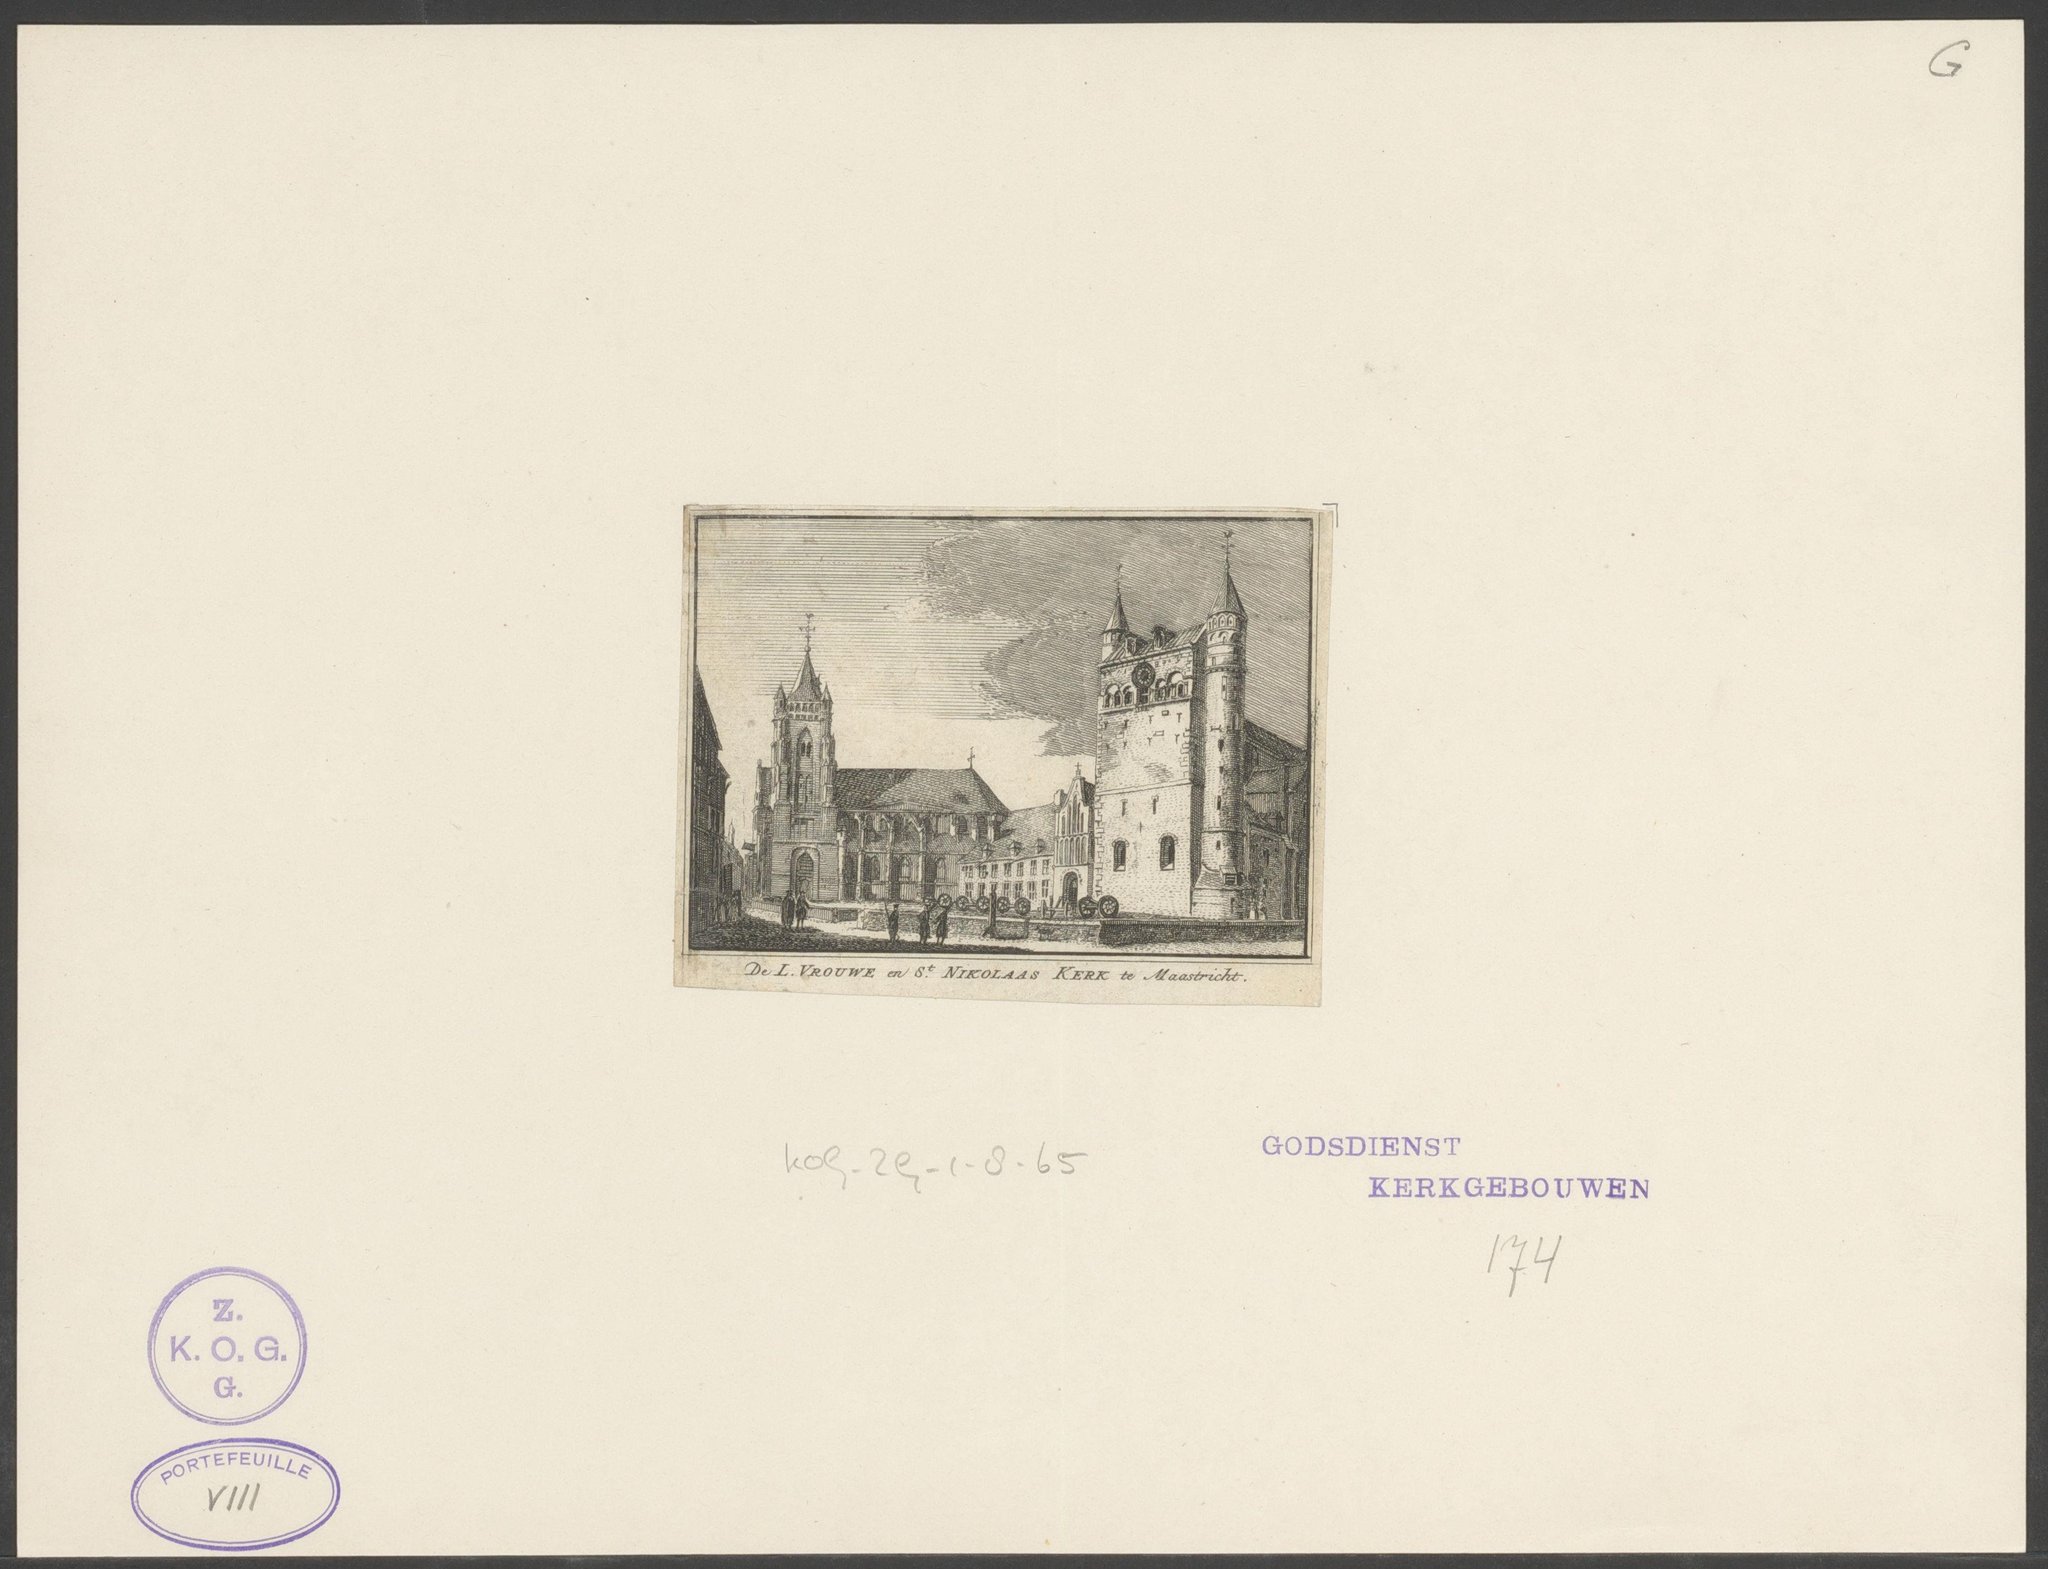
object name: print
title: Gezicht op de Onze-Lieve-Vrouwebasiliek te Maastricht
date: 1746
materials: paper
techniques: engraving, etching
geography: netherlands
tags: church (exterior)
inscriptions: collector's mark: Lugt 1641, collector's mark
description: Prent eerst gebruikt in: Spilman, Hendrik. Het verheerlykt Nederland, of kabinet van hedendaagsche gezigten. 9 dln. Amsterdam: Isaac Tirion, 1745-1774, dl. 2 (1746), ill. 127-128. Later in: Nederlandsche tafereelen; of eene keurige verzameling van negen honderd fraaije gezigten van steden, dorpen, sloten, oudheden (...). 9 delen. Amsterdam: Jan de Groot, 1792, dl. 2, ill. 127-128.